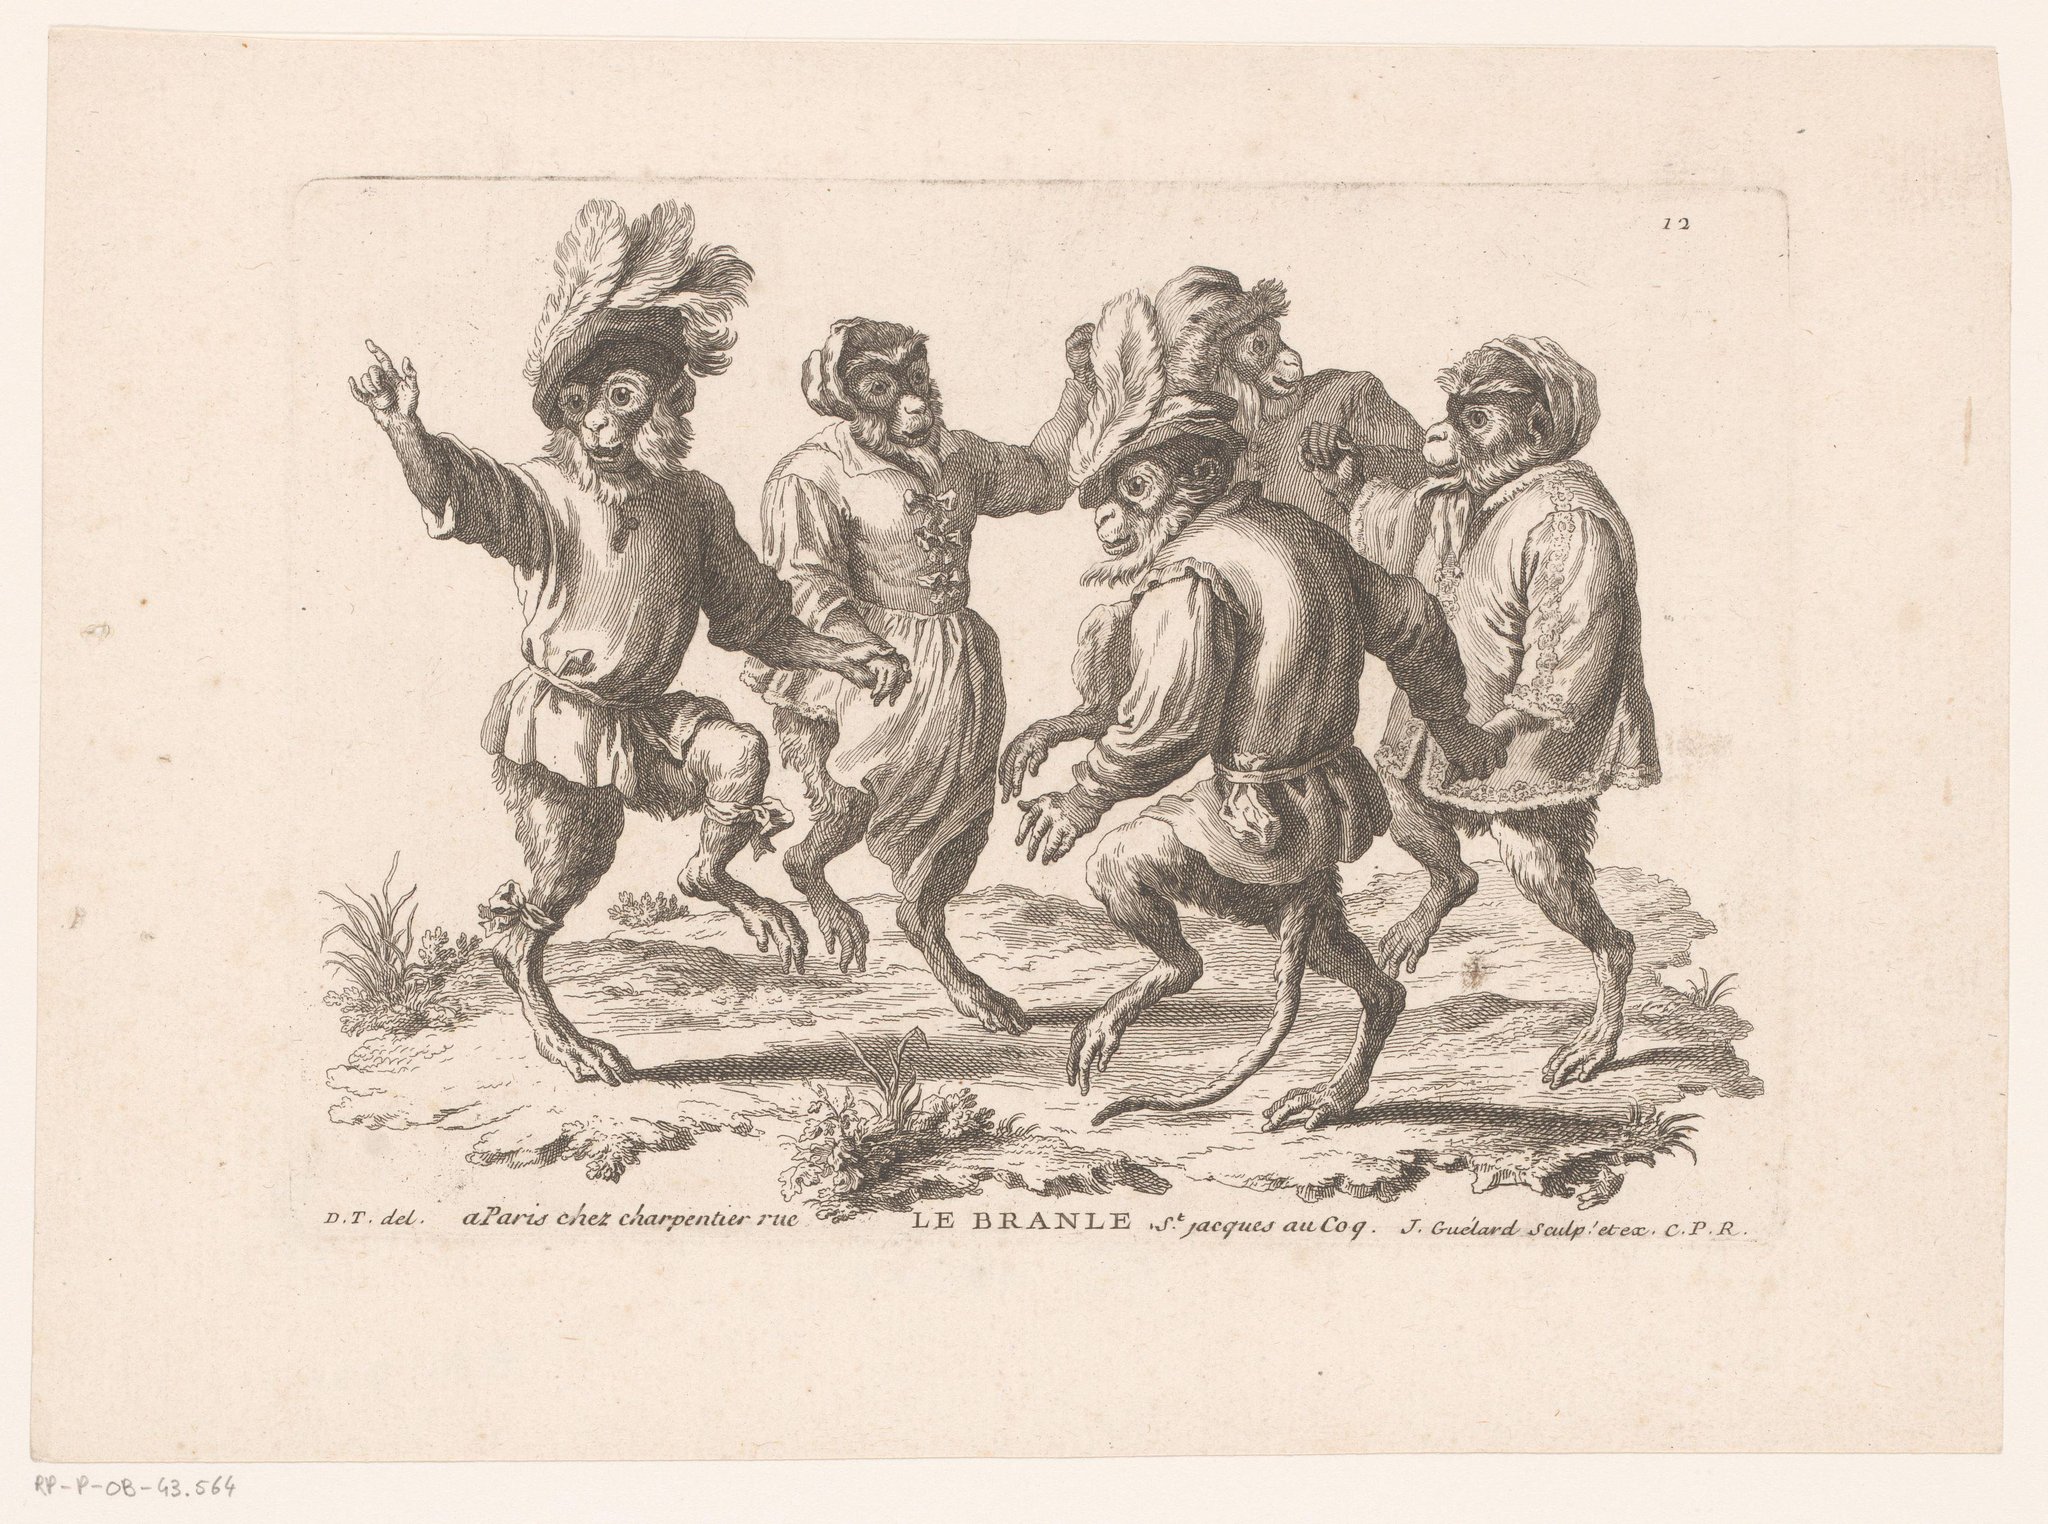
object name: print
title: Singeries ou differentes Actions de la Vie humaine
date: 1733-1792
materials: paper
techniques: etching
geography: paris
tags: dancing, monkeys, apes, animals acting as human beings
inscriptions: collector's mark: Lugt 2228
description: Maakt deel uit van een twaalfdelige serie getiteld 'Singeries ou differentes Actions de la Vie humaine', met apenspelen. De serie bestaat uit twee delen met elk twaalf platen en een opdracht. Deze serie is opgedragen aan het publiek (Au Public). Het andere deel werd opgedragen aan Monsieur de l'Orme van de Ménagerie de Versailles. De serie werd initieel uitgegeven door Guélard en de weduwe van Chéreau. Dit betreft waarschijnlijk een door het IFF onbeschreven latere staat, uitgegeven door Étienne Charpentier.